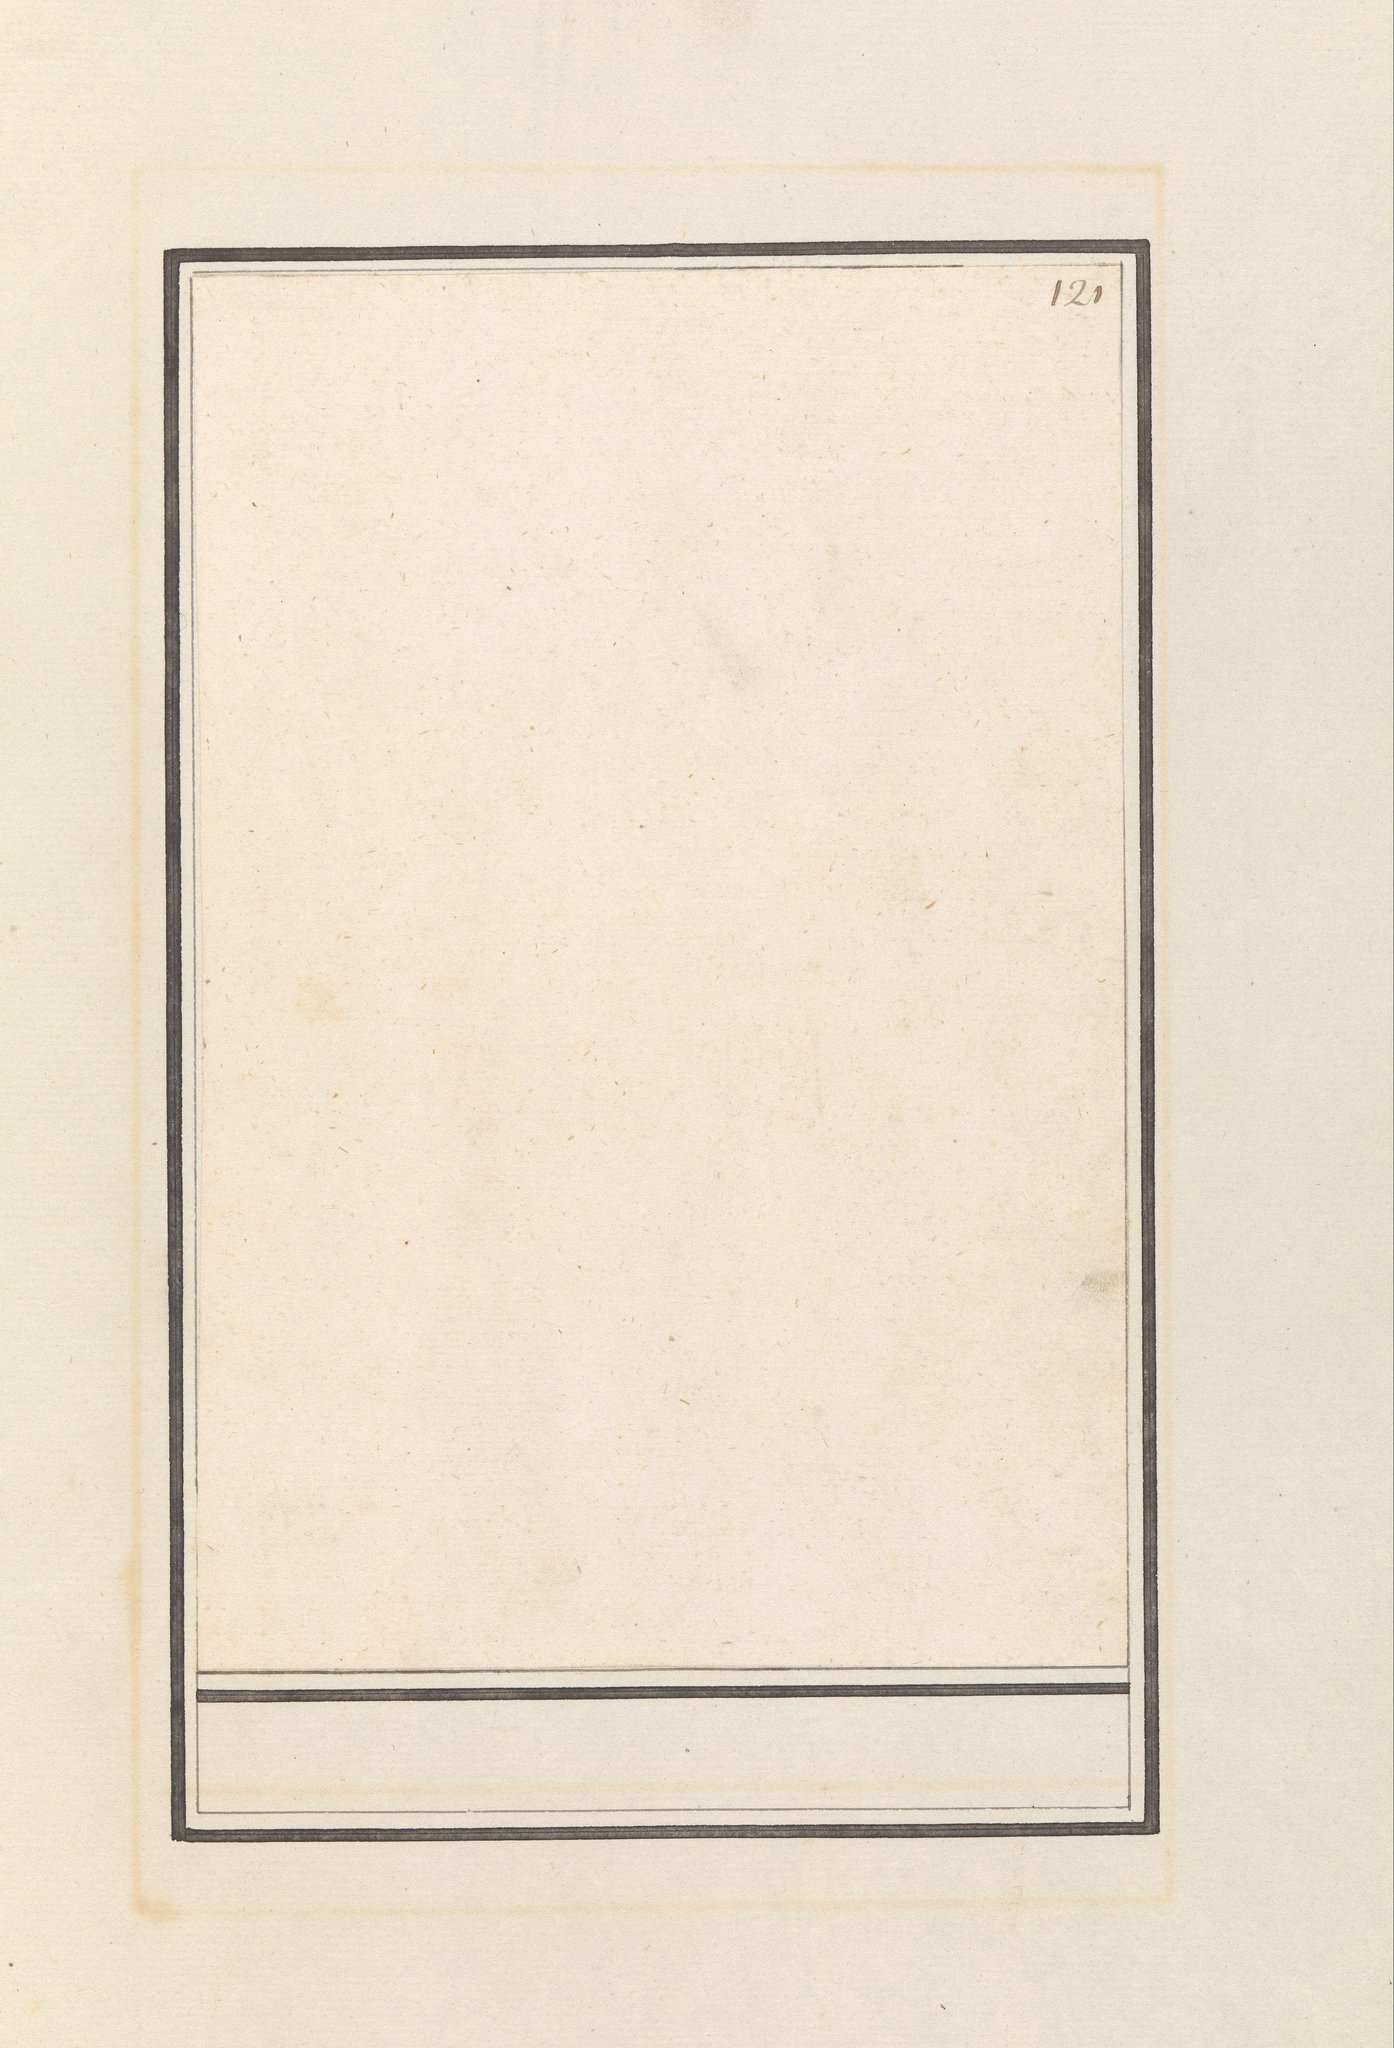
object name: drawing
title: Leeg blad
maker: Anonymous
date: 1809-1814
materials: paper, watercolor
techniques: brush, pen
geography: southern netherlands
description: Leeg blad, opgeplakt binnen omlijsting. Rechtsboven genummerd: 121. Onderdeel van het tweede album met tekeningen van bloemen en planten. Negende van twaalf albums met tekeningen van dieren, vogels en planten bekend rond 1600, gemaakt in opdracht van keizer Rudolf II. Met toelichting in Nederlands, Latijn en Frans.